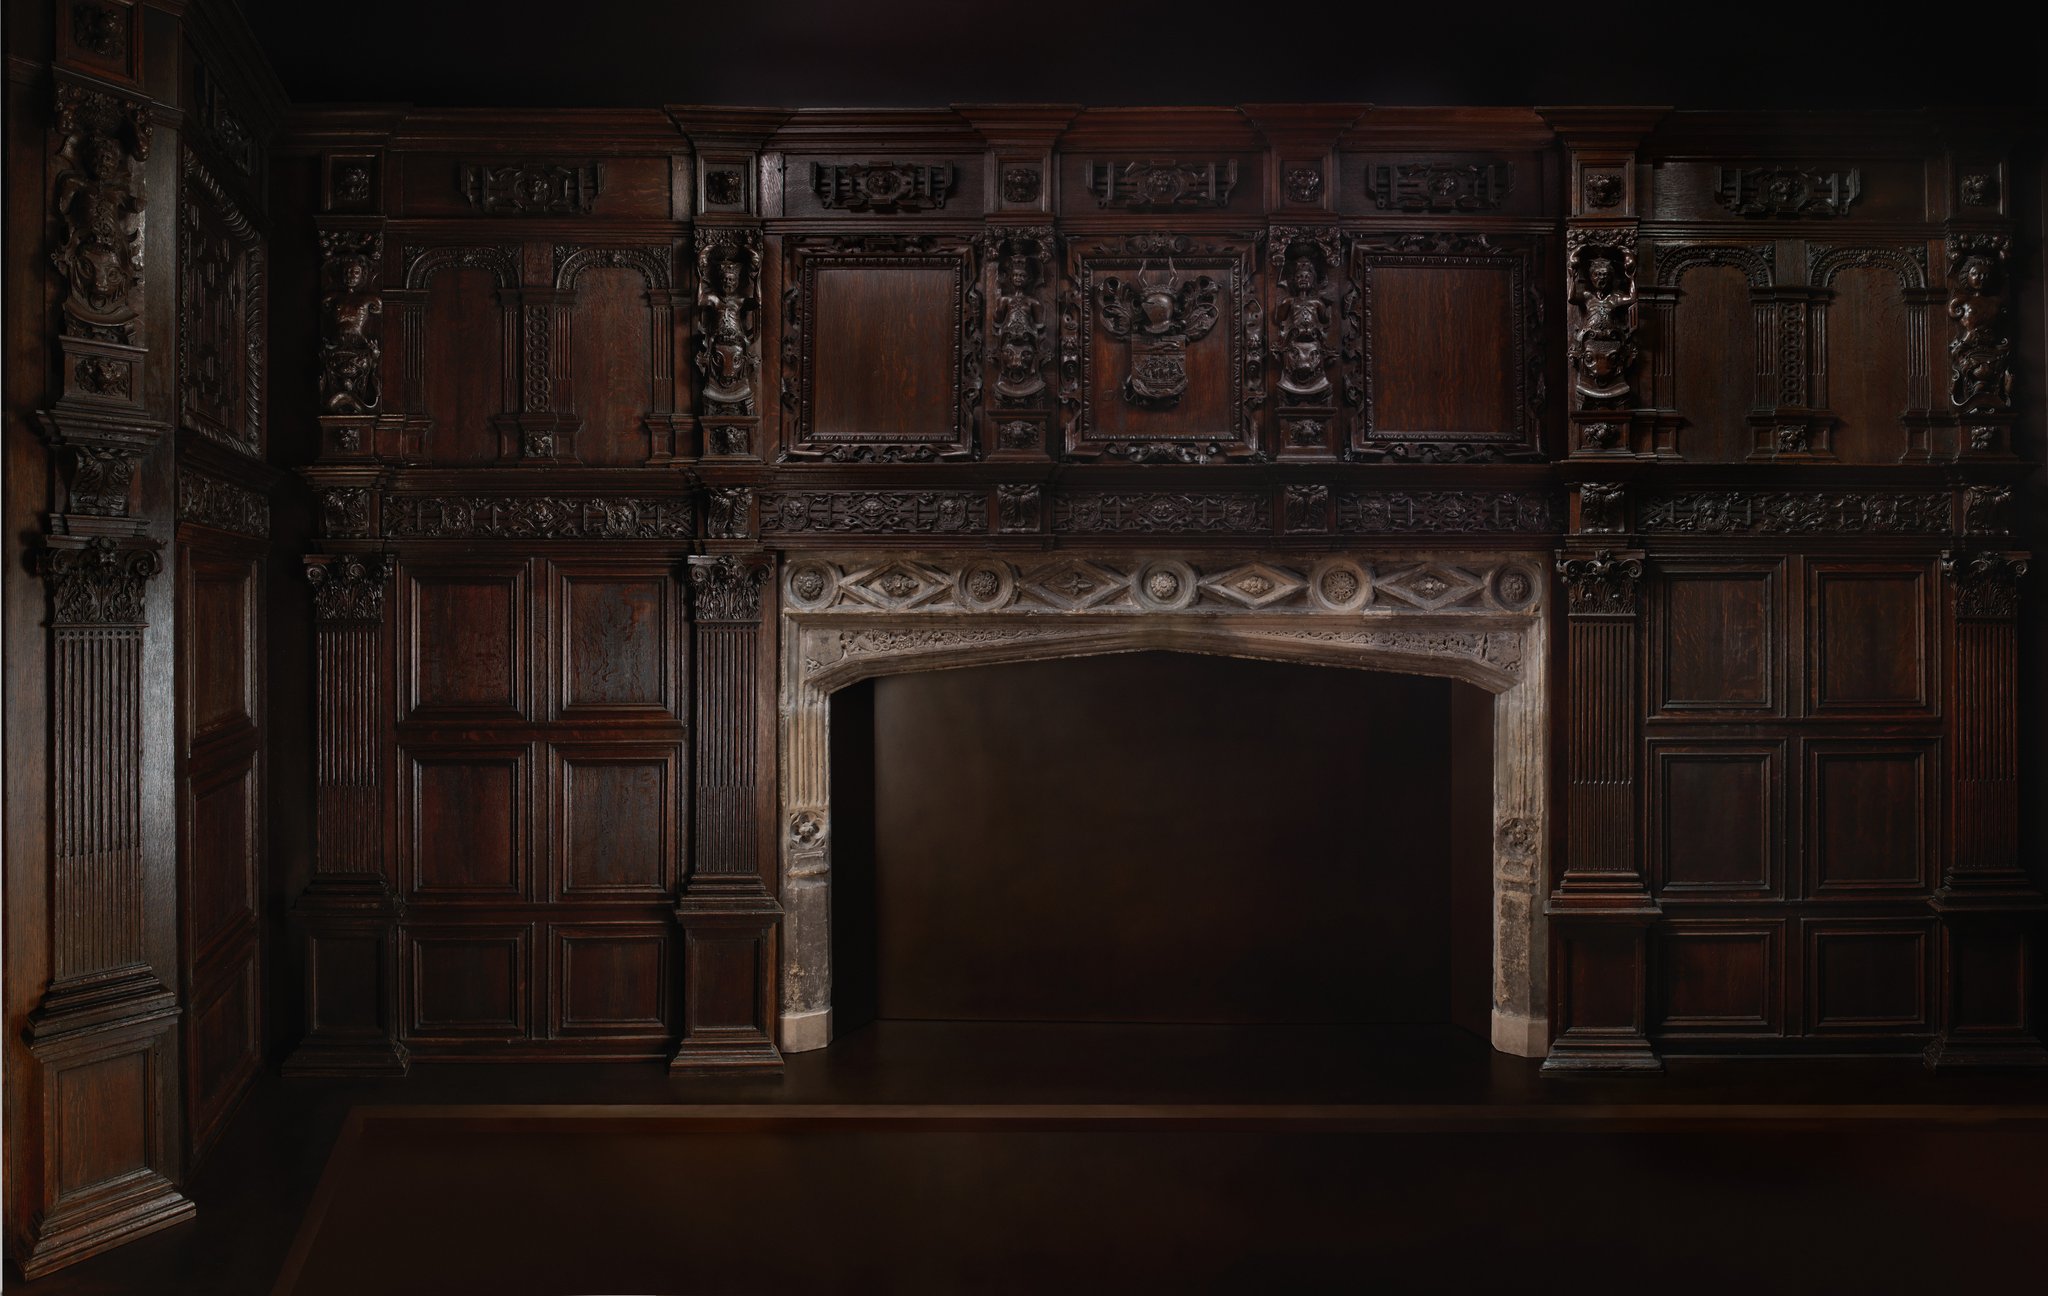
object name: room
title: Paneling from a house on the Hall Quay, Great Yarmouth, Norfolk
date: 1600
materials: wood